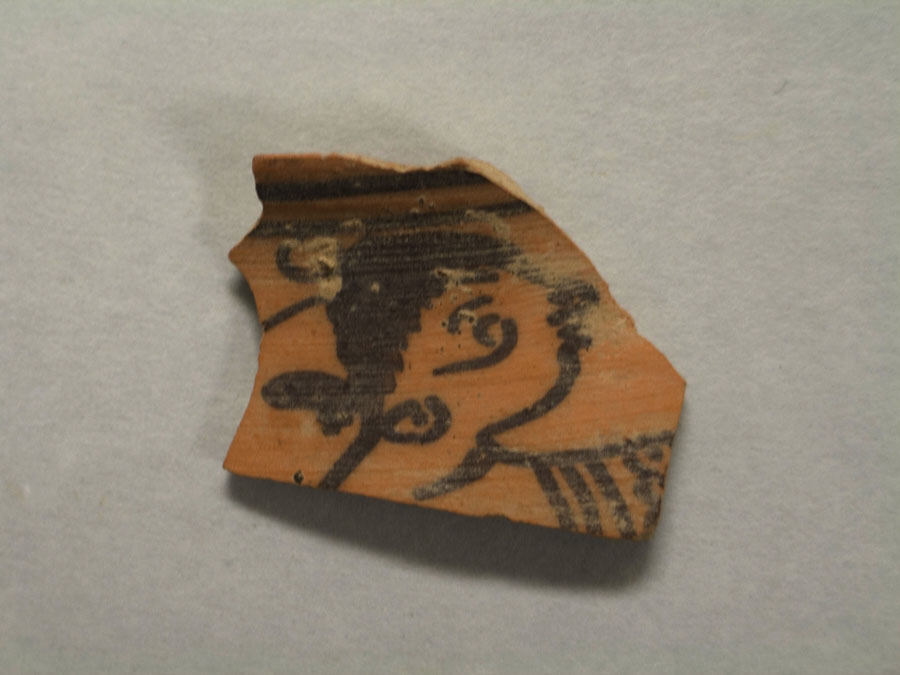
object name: shard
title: Shard: Head of Figure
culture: pakistani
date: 301-500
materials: terracotta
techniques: painting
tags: gandhara,heads